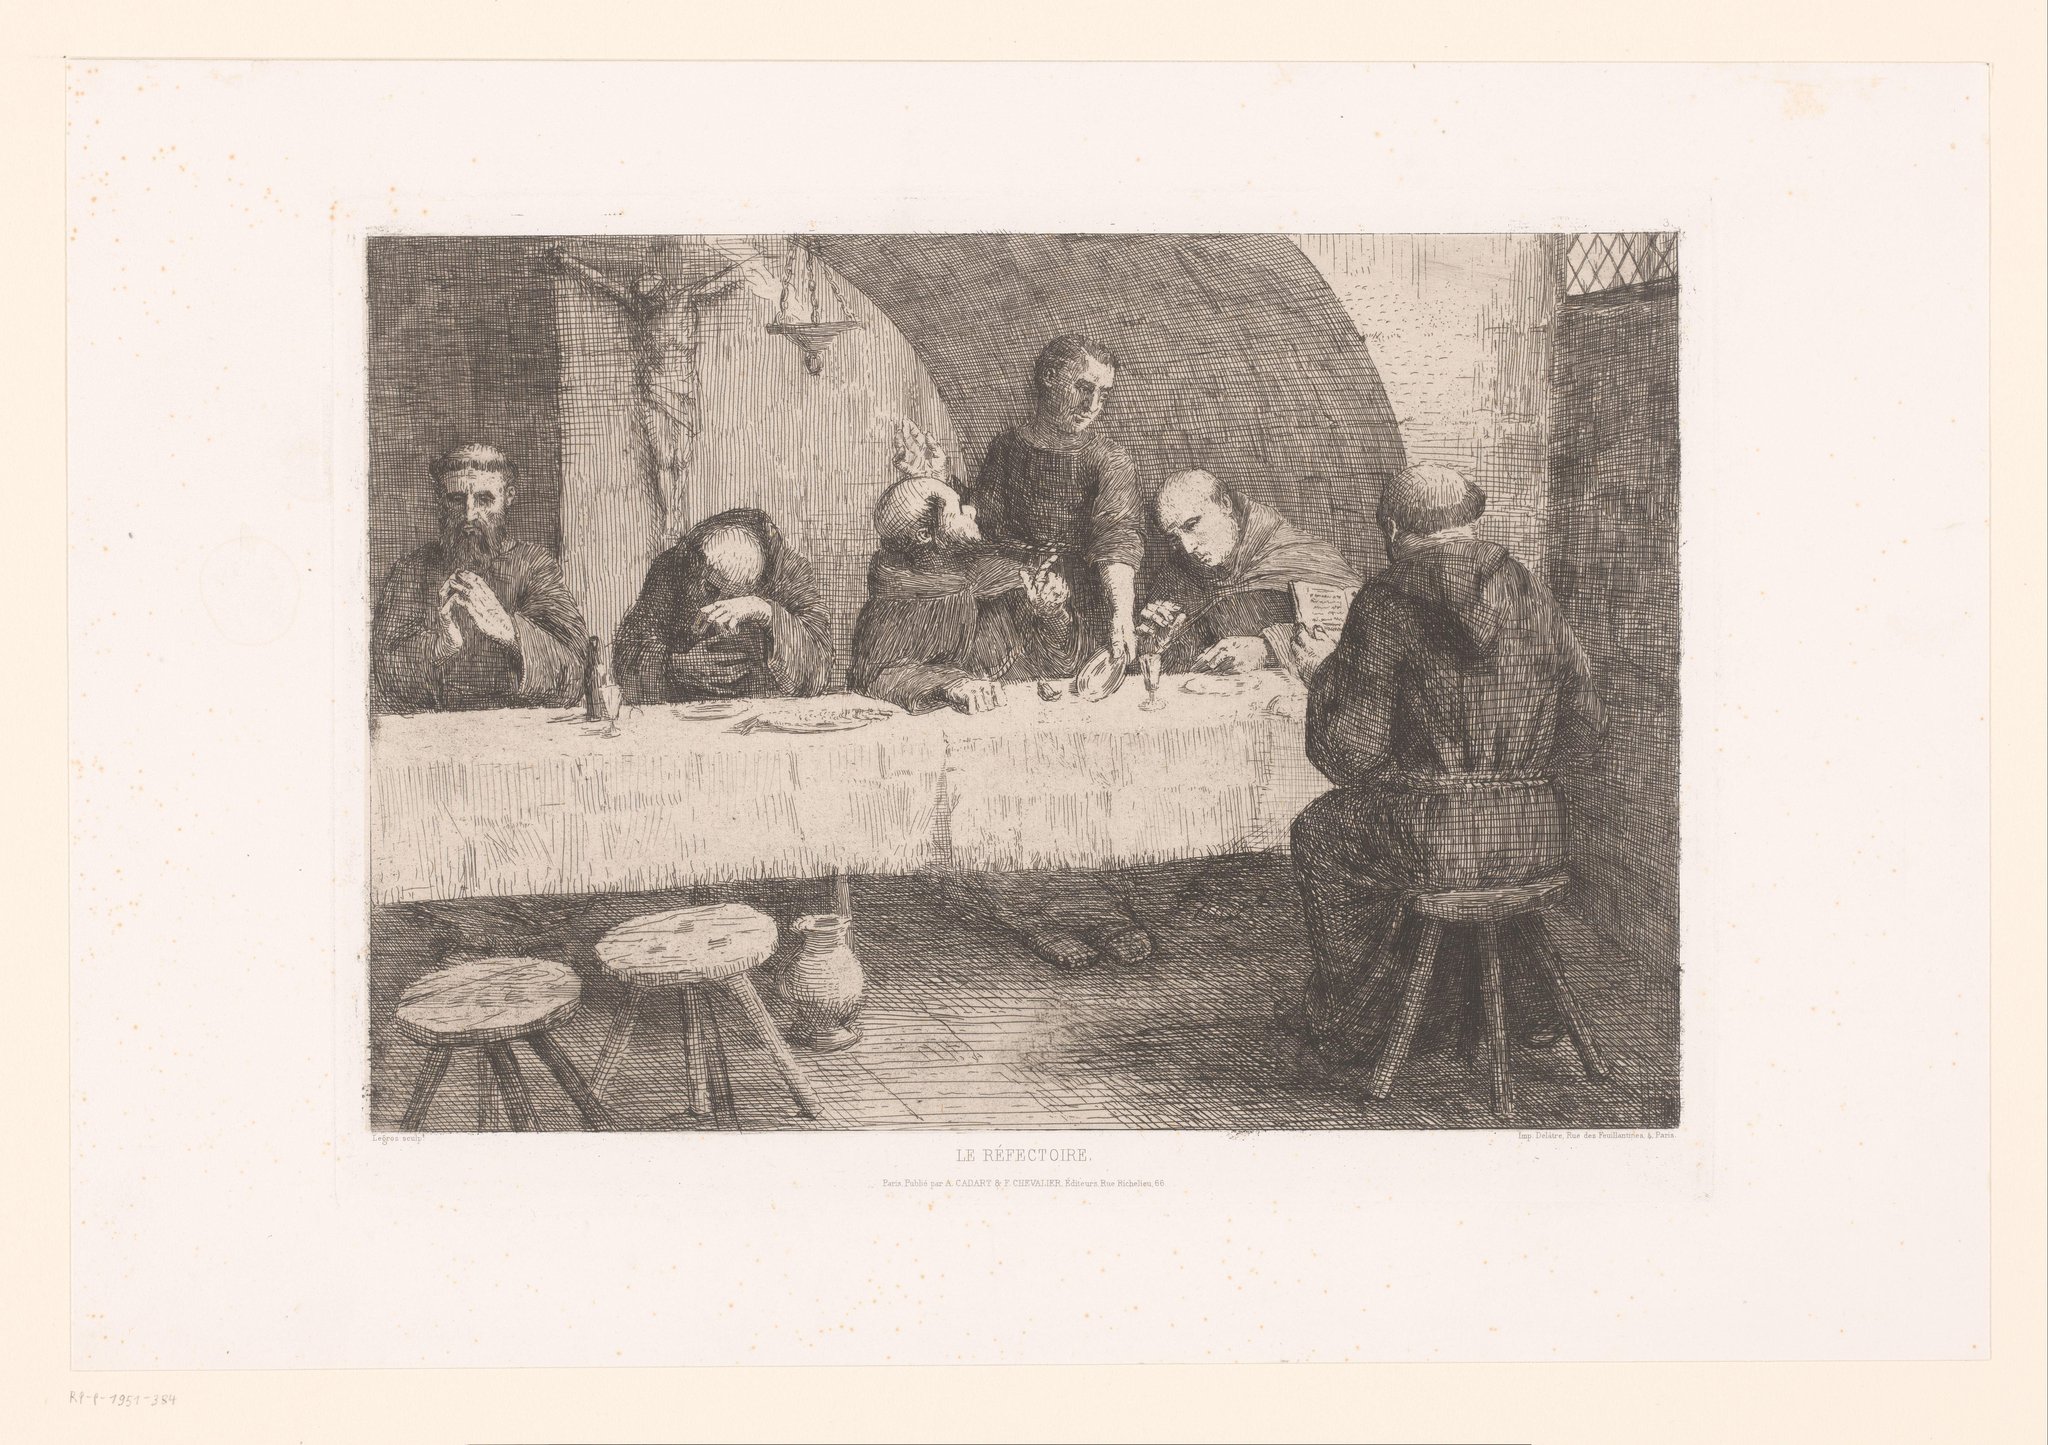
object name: print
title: Le réfectoire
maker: alphonse legros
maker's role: print maker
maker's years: 1837-1911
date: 1863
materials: paper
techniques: etching, intaglio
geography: paris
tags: refectory ~ monastery, one person praying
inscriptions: collector's mark: Lugt 2228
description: Gepubliceerd in: Société des Aquafortistes, 1863.